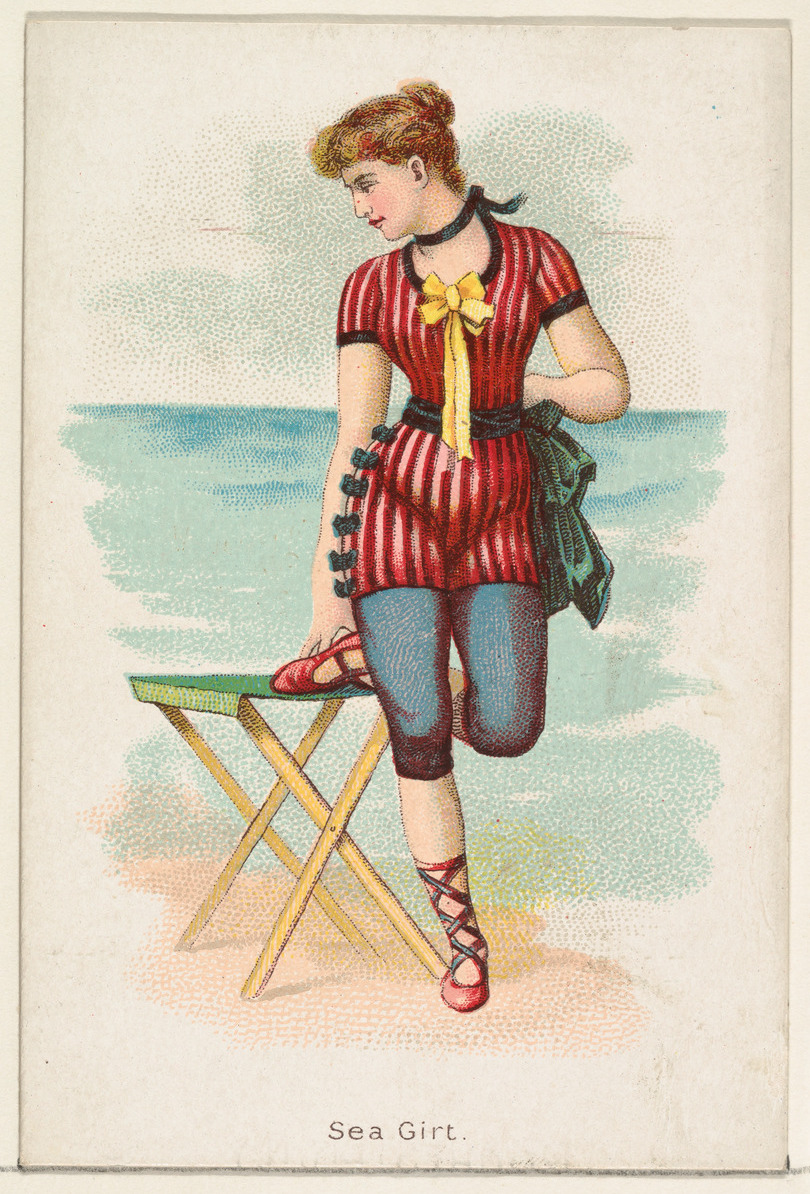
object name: print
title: Sea Girt, from the Beautiful Bathers series (N192) issued by Wm. S. Kimball & Co.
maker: william s. kimball & company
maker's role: publisher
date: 1889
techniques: color lithograph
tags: profiles,women